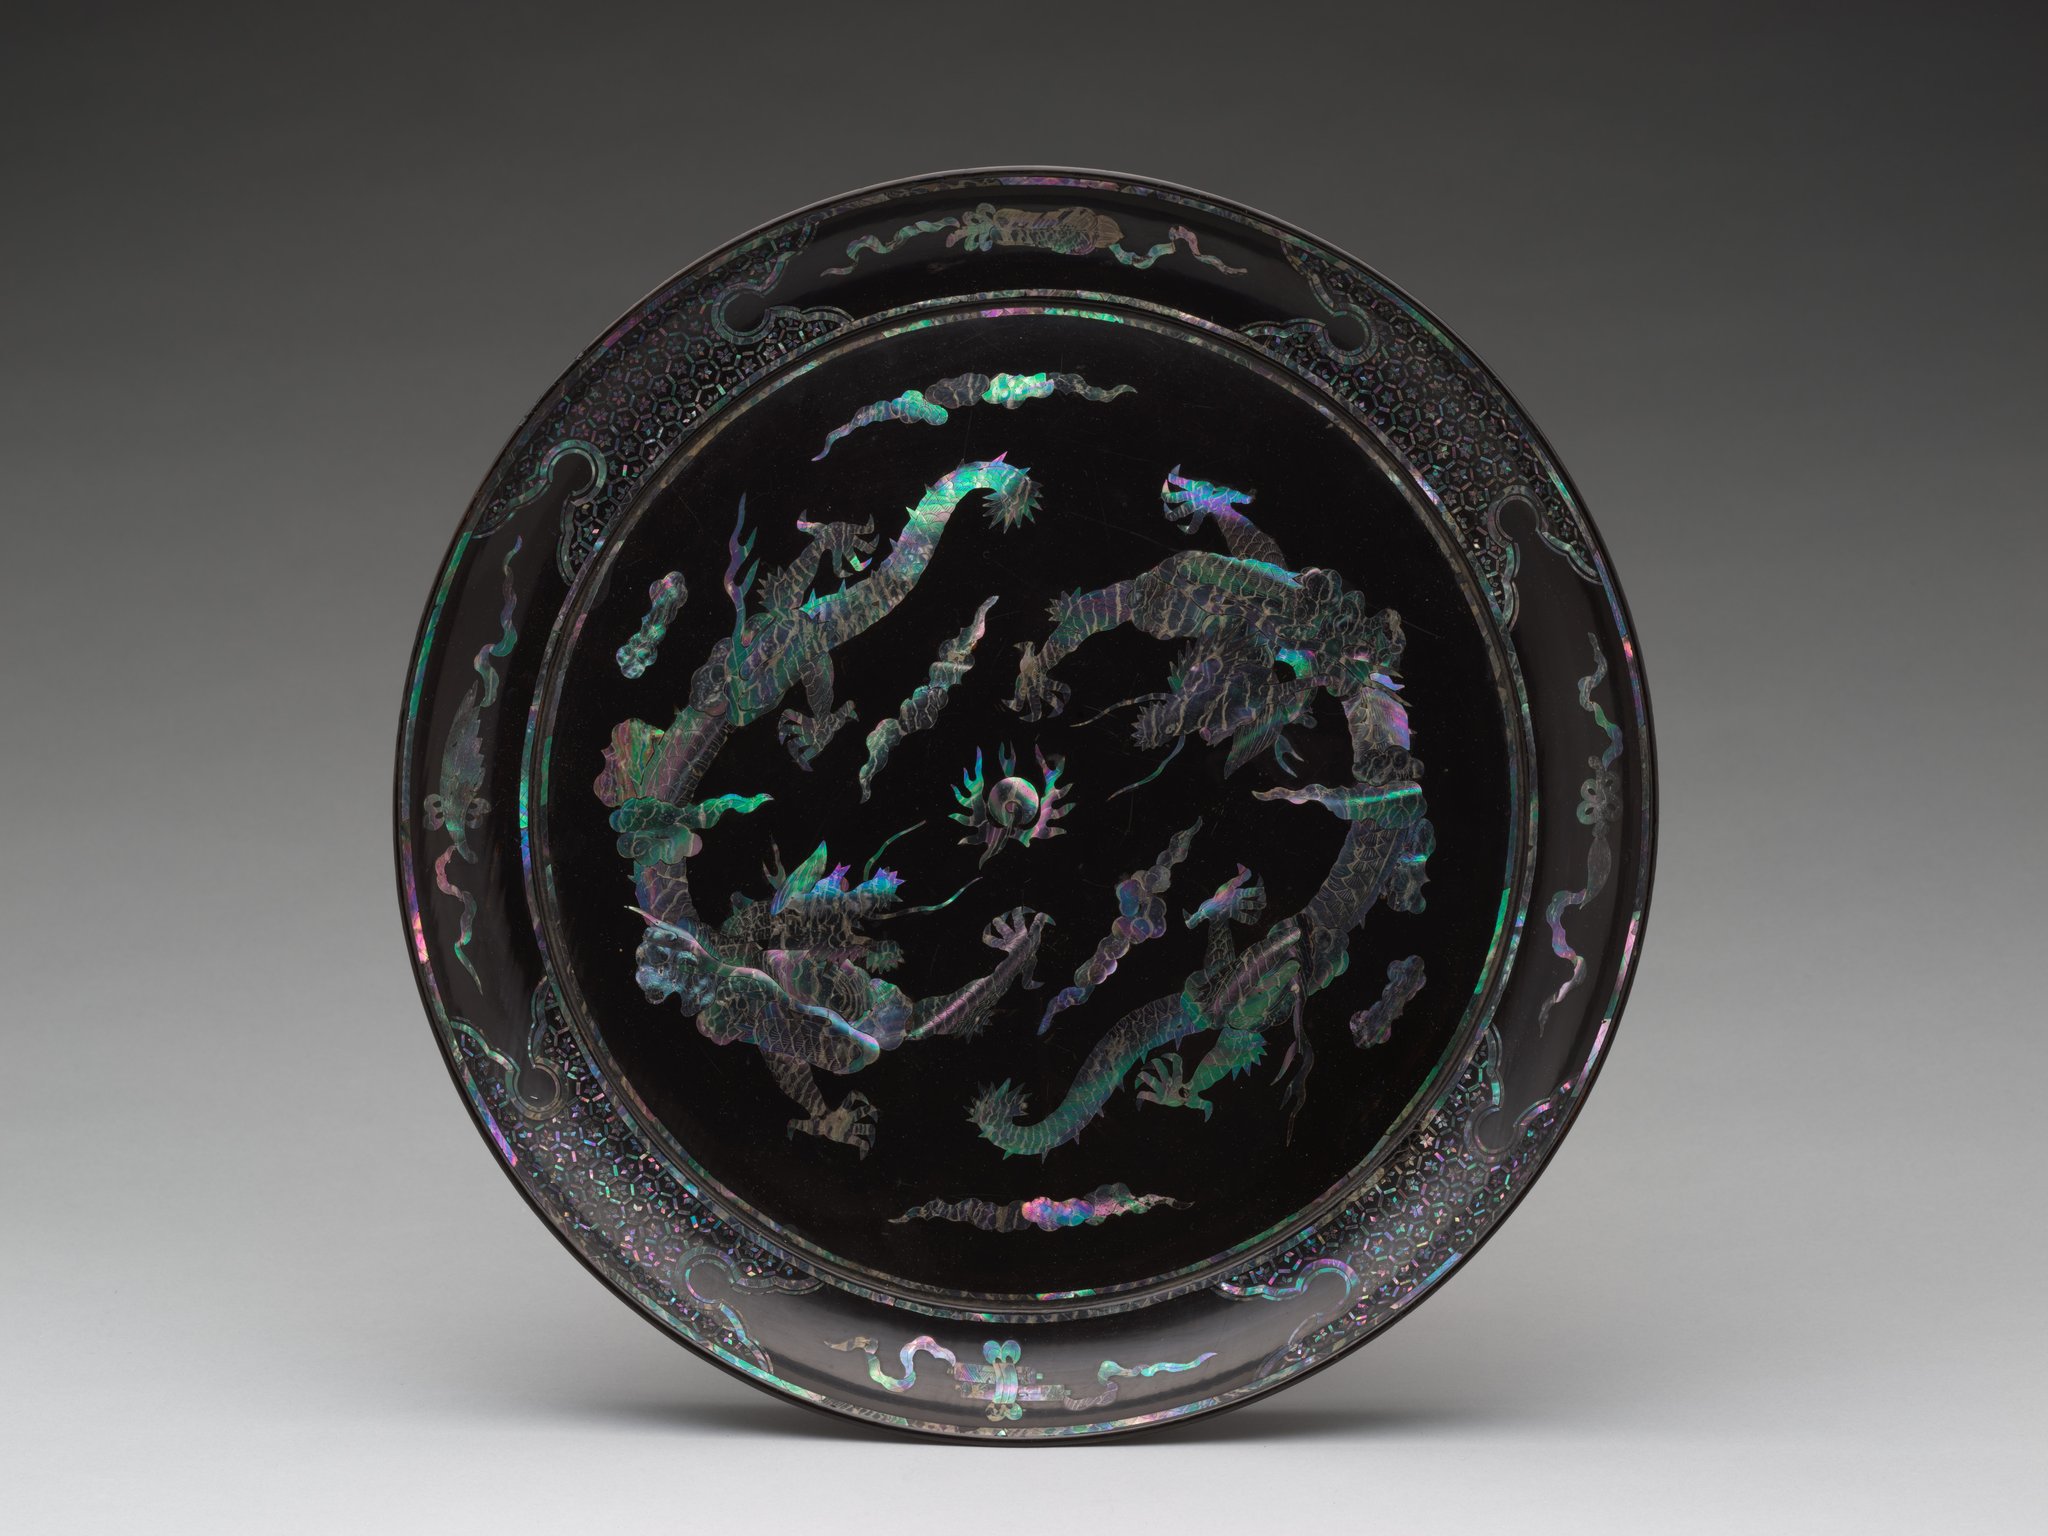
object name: tray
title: Round tray with decoration of dragons and clouds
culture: japanese or ryukyuan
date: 1601-1800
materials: lacquer, mother of pearl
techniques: inlay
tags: dragons